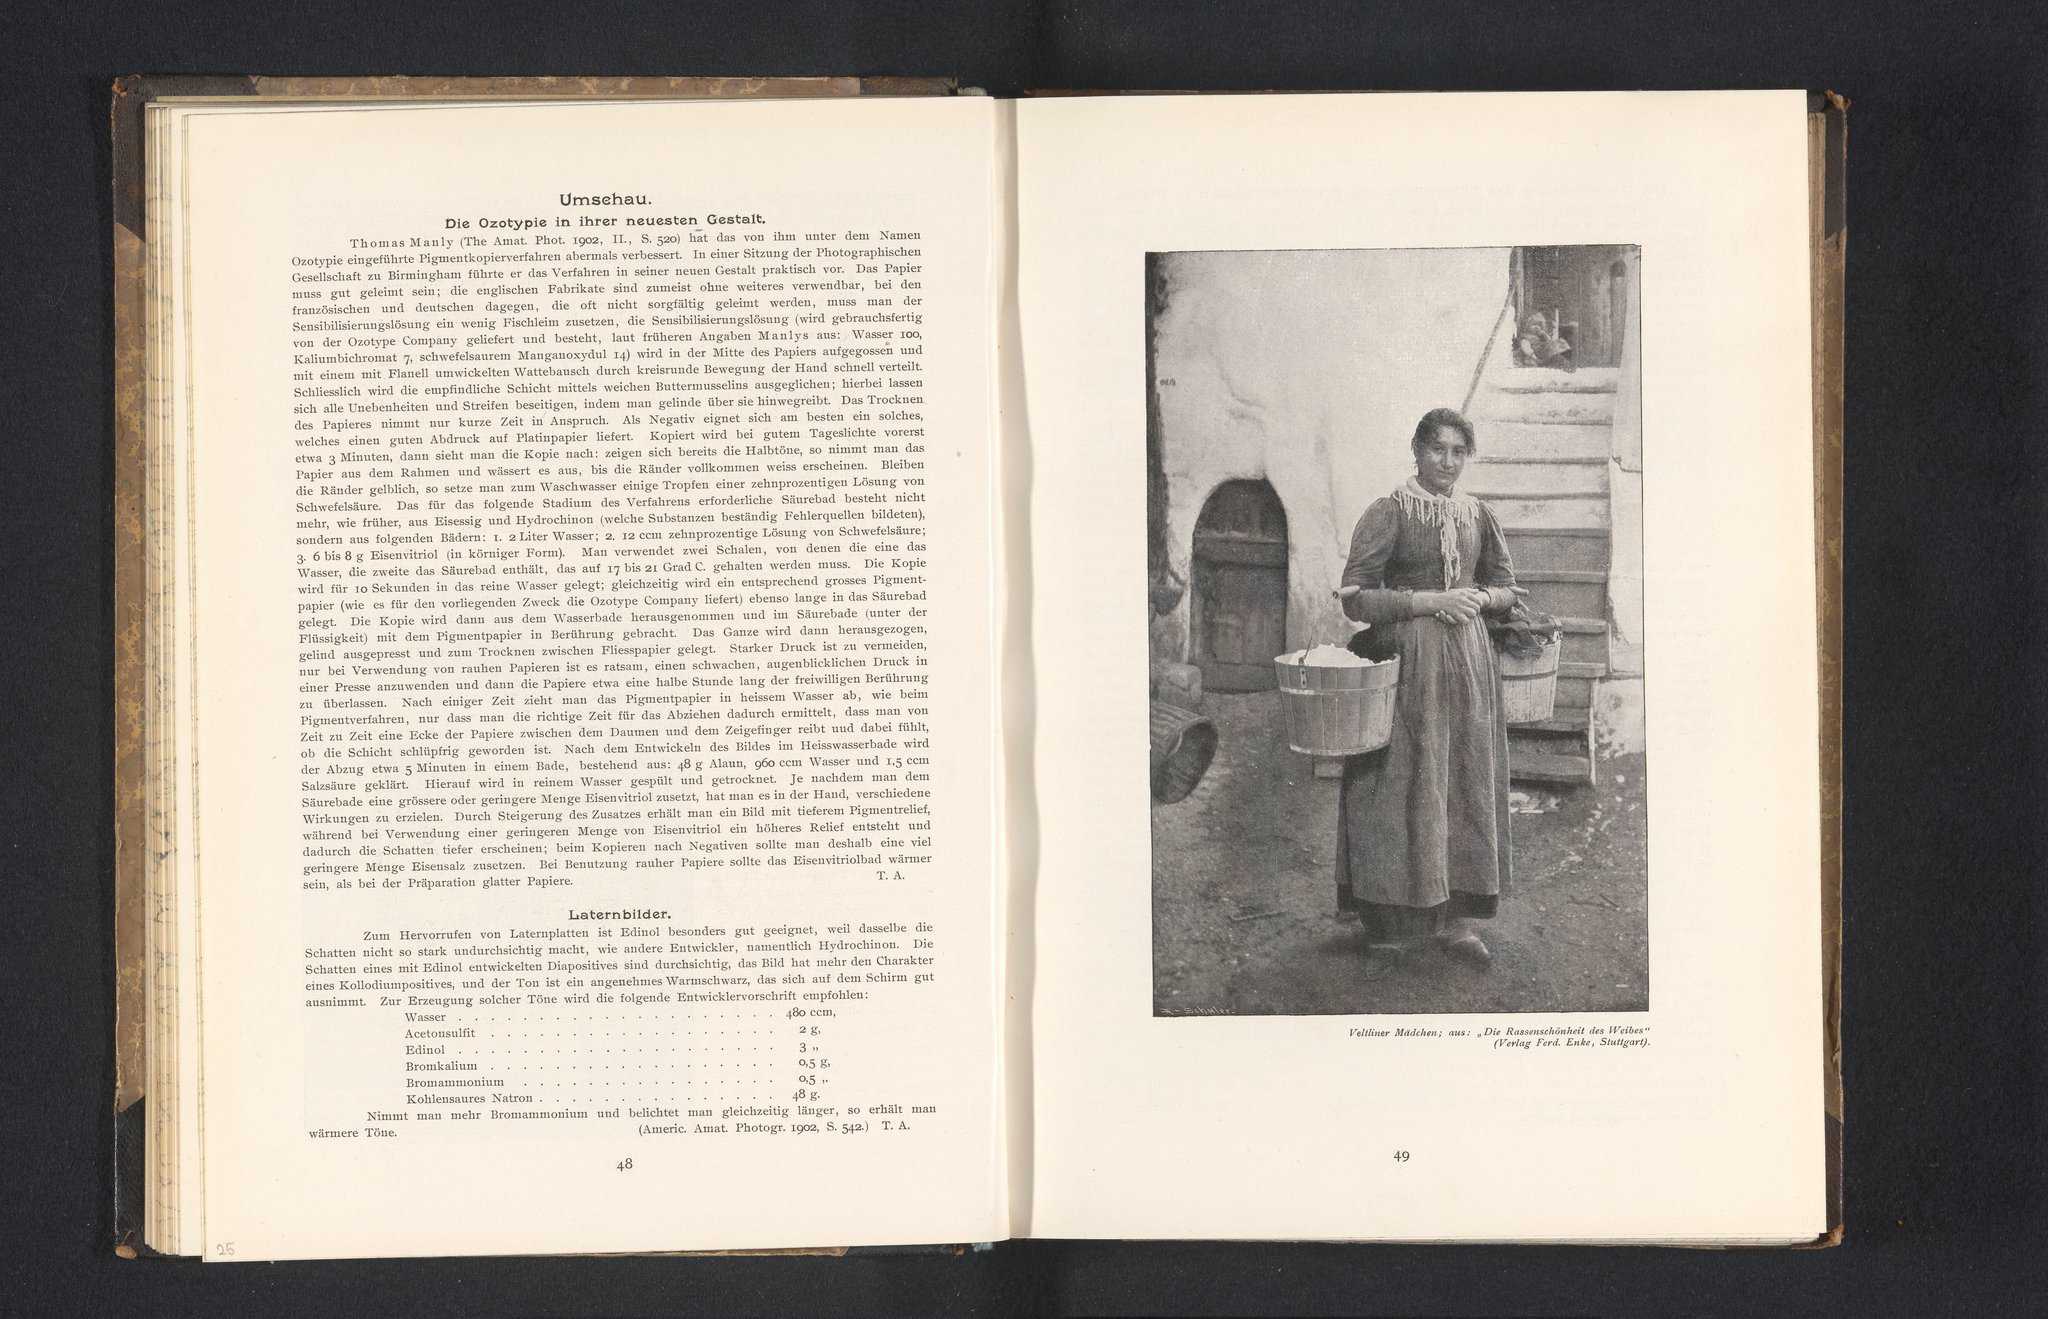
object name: page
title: Veltliner Mädchen; aus: "Die Rassenschönheit des Weibes"/ (Verlag Ferd. Enke, Stuttgart)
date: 1898-1903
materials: paper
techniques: autotype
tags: historical persons not known by name - bb - woman, laundering